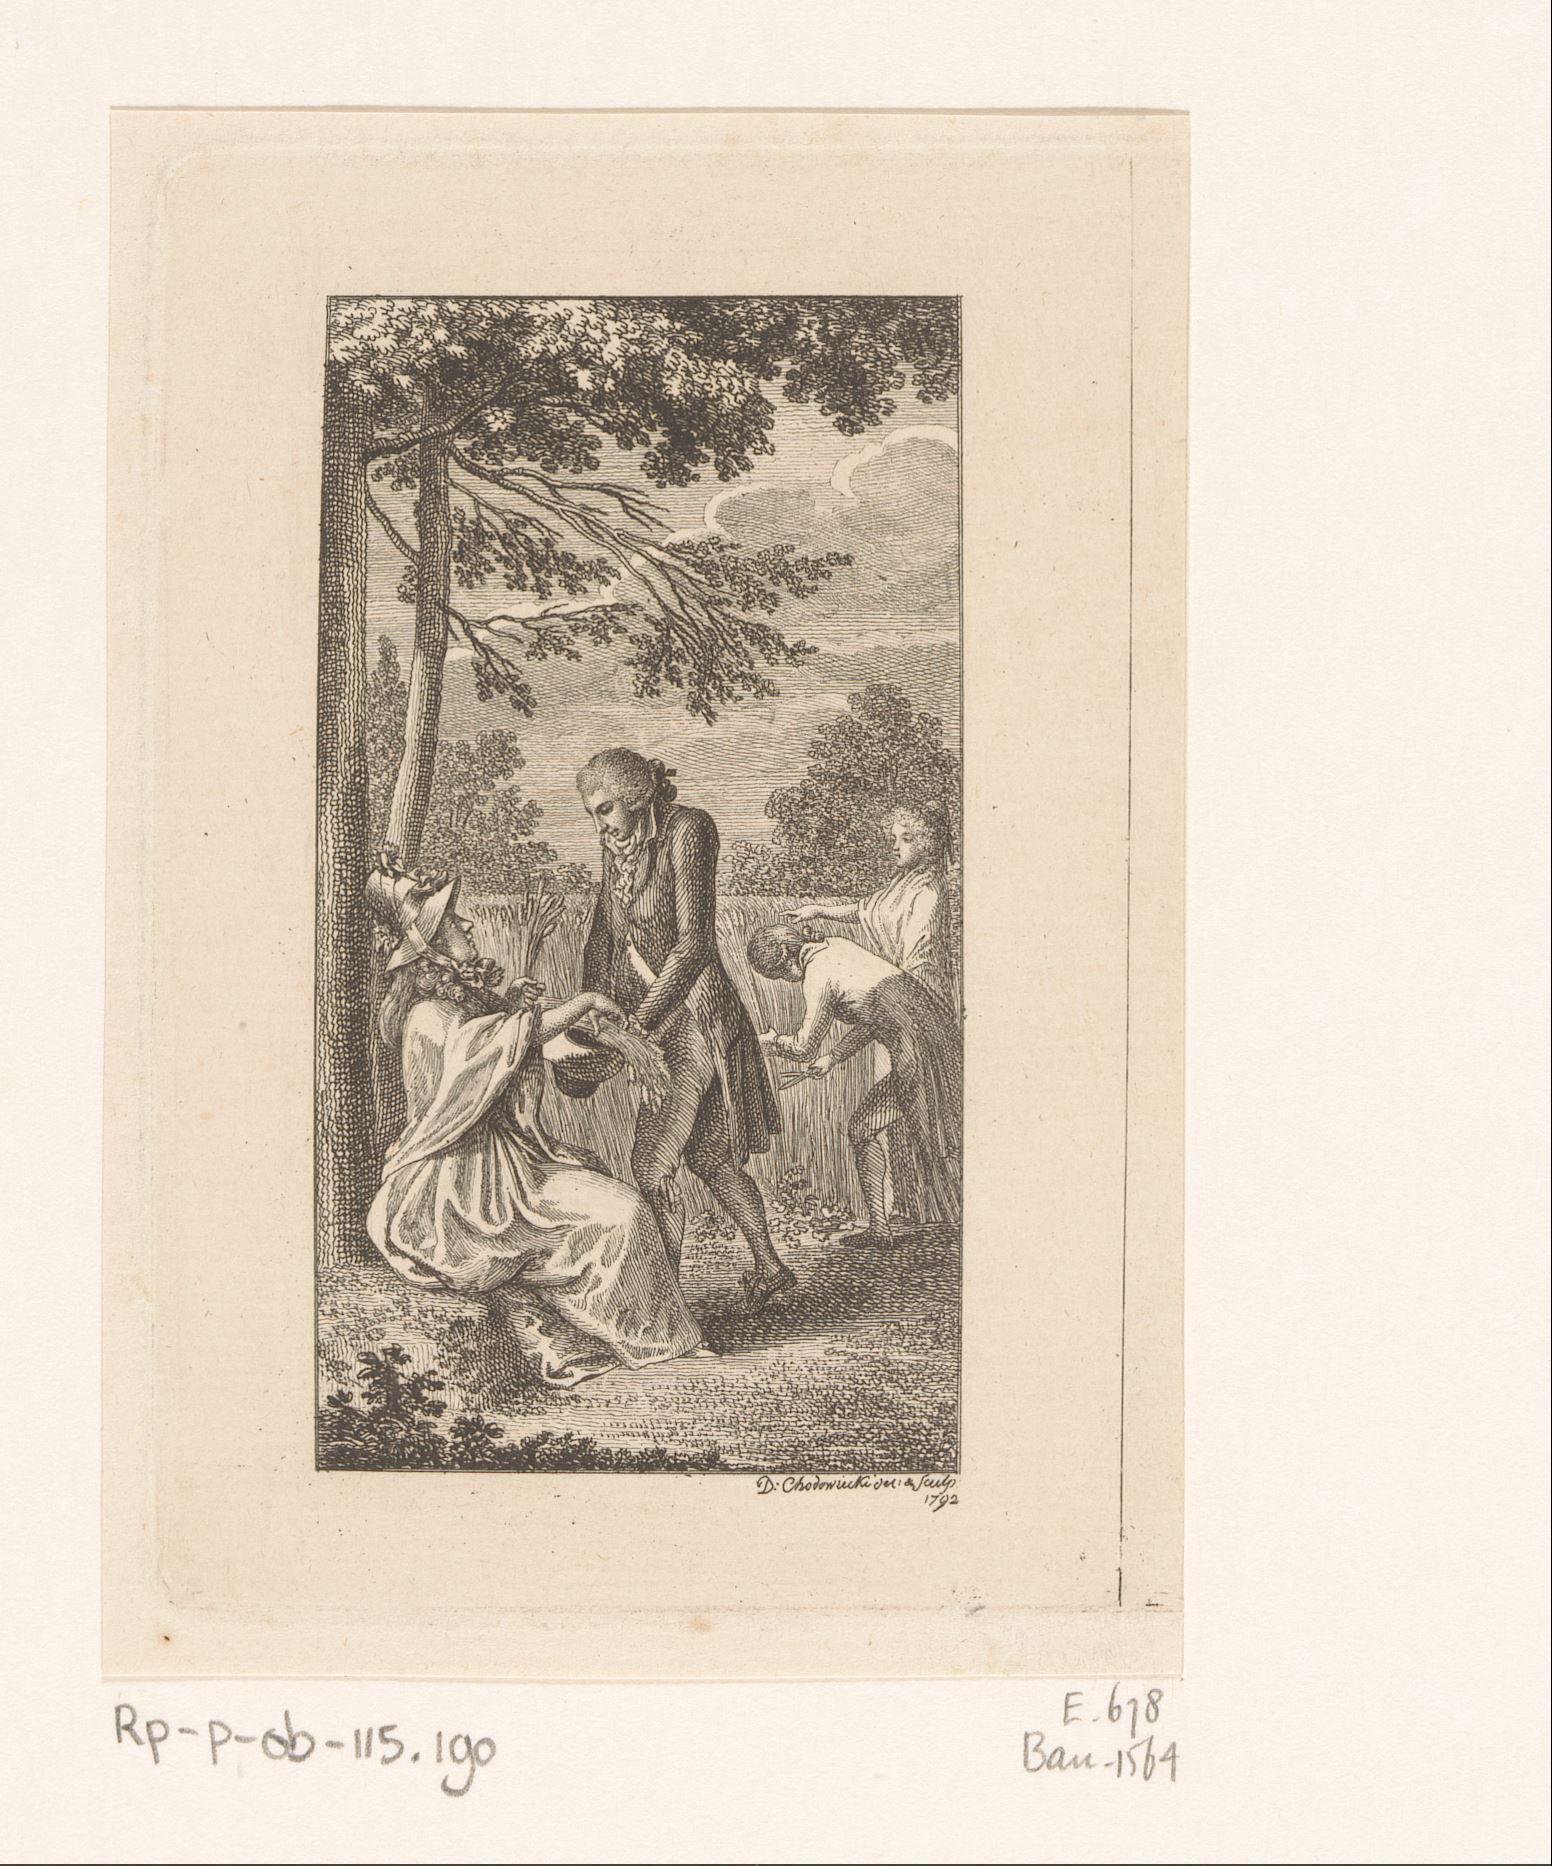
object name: print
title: Aren lezen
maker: daniel nikolaus chodowiecki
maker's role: draughtsman, print maker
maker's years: 1726-1801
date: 1792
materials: paper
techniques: etching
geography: berlin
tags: gleaning, lovers; courting, flirting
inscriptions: collector's mark: Lugt 2228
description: Prent gebruikt voor: Aehrenlese vom Calenderfelde, bestehend in einer Auswahl vorzüglicher Aufsätze aus Deutschlands Taschenbüchern. Berlijn: F. T. Lagarde, 1792.